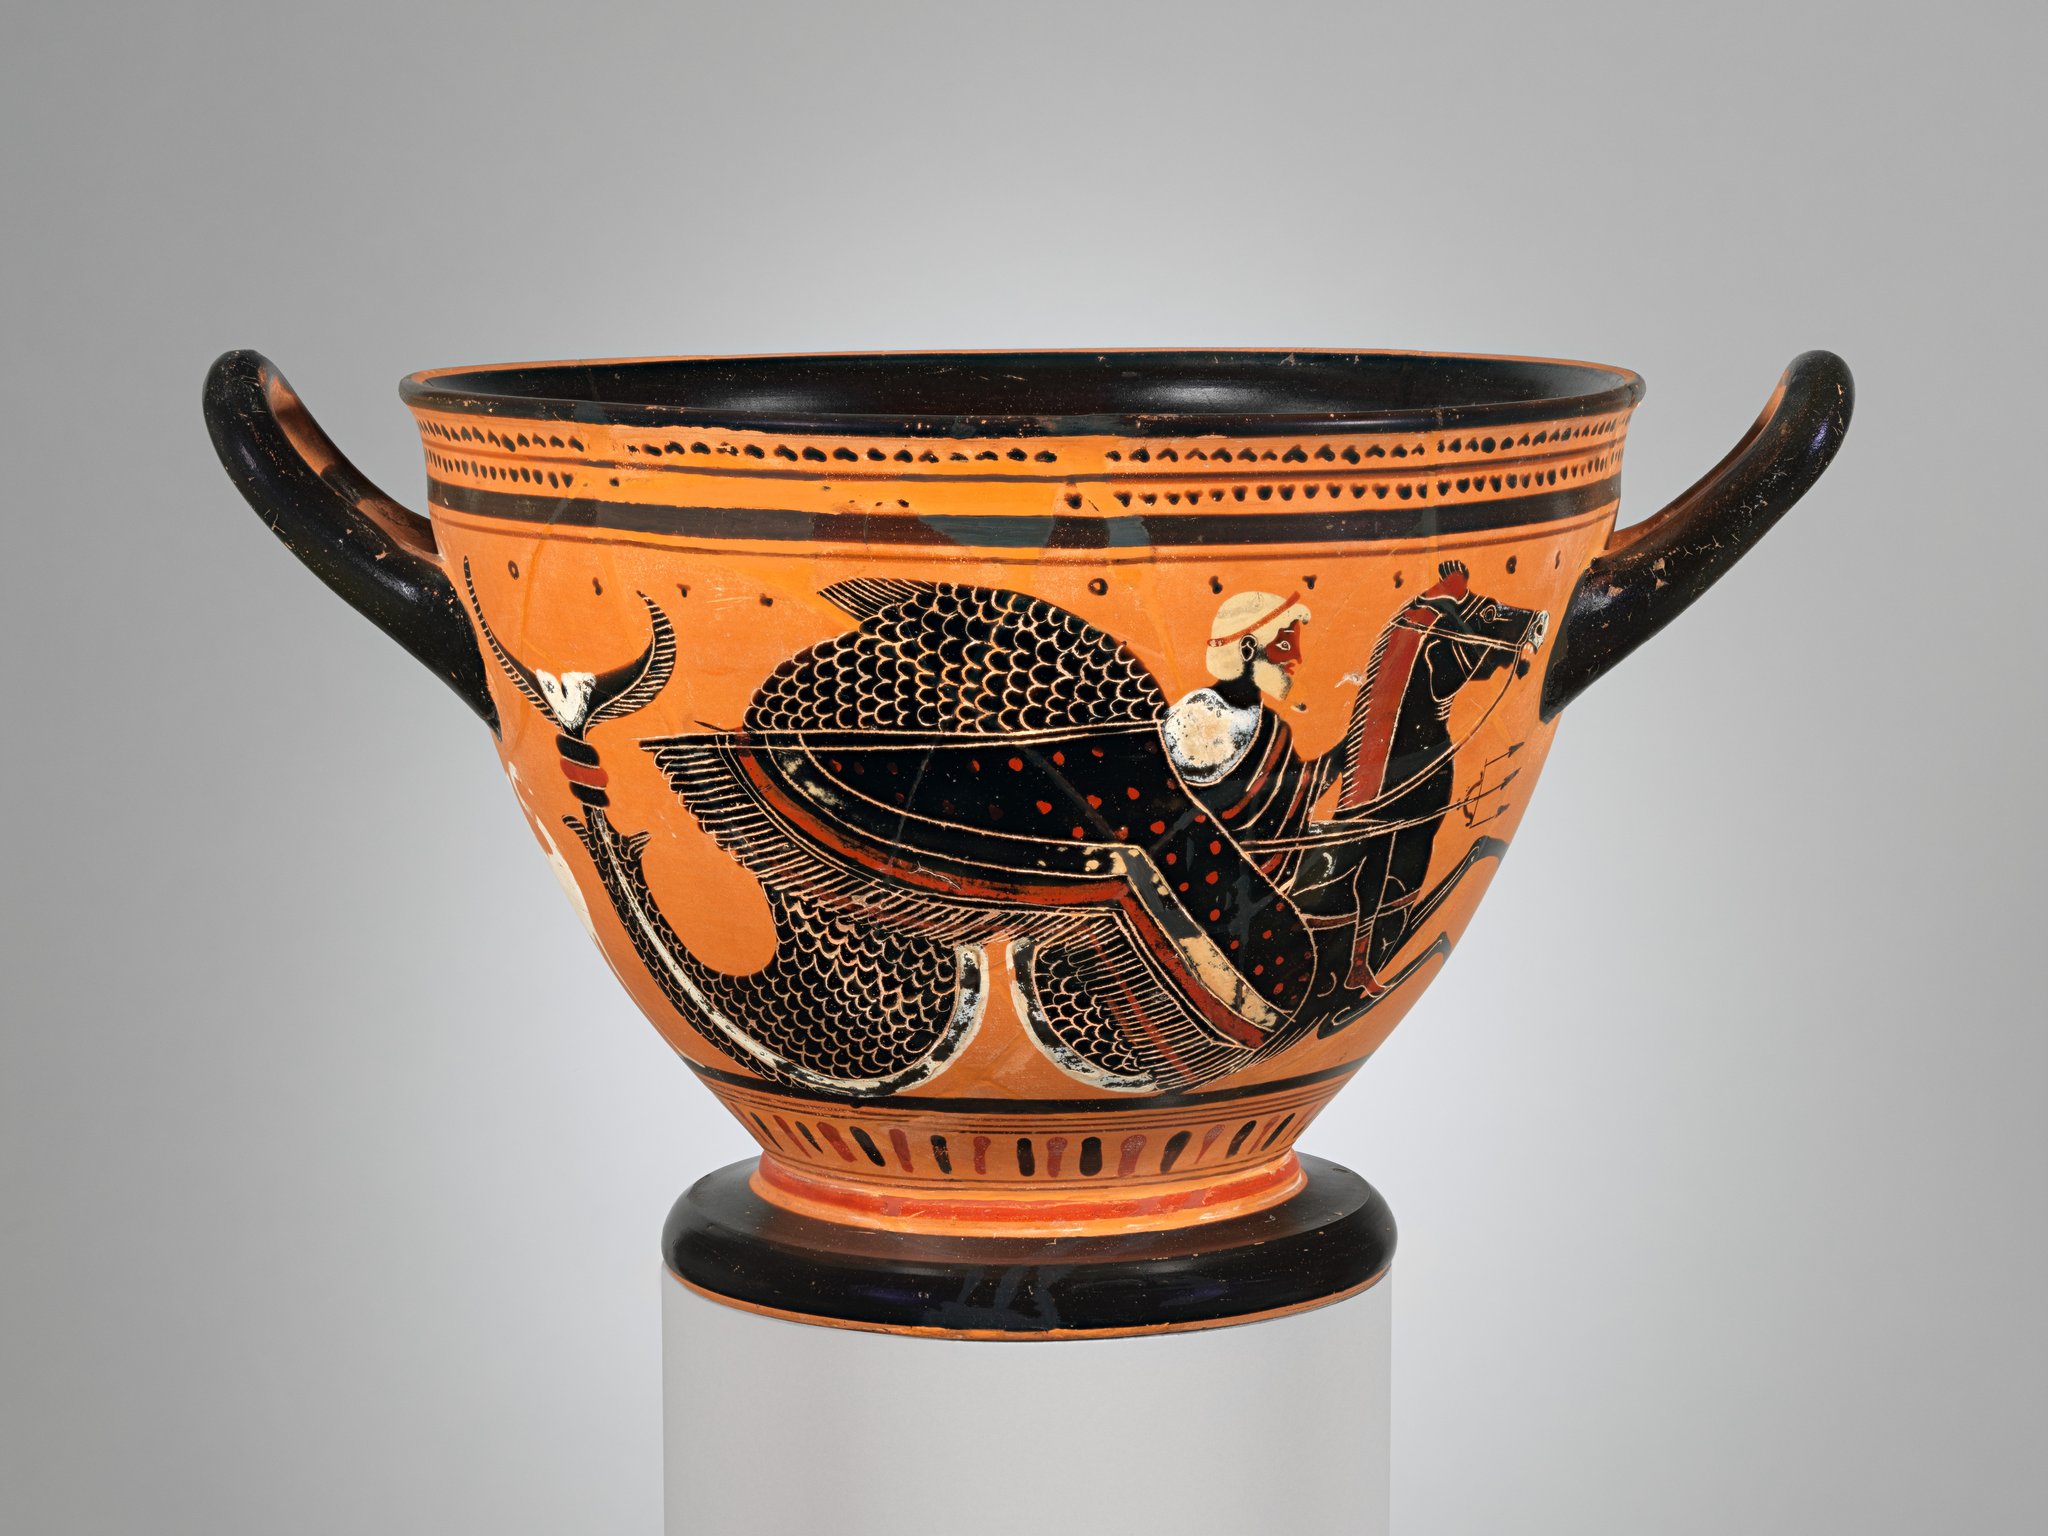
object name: skyphos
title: Terracotta skyphos (deep drinking cup)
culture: greek, attic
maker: theseus painter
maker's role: artist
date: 500 BCE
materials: terracotta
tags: poseidon,seahorses